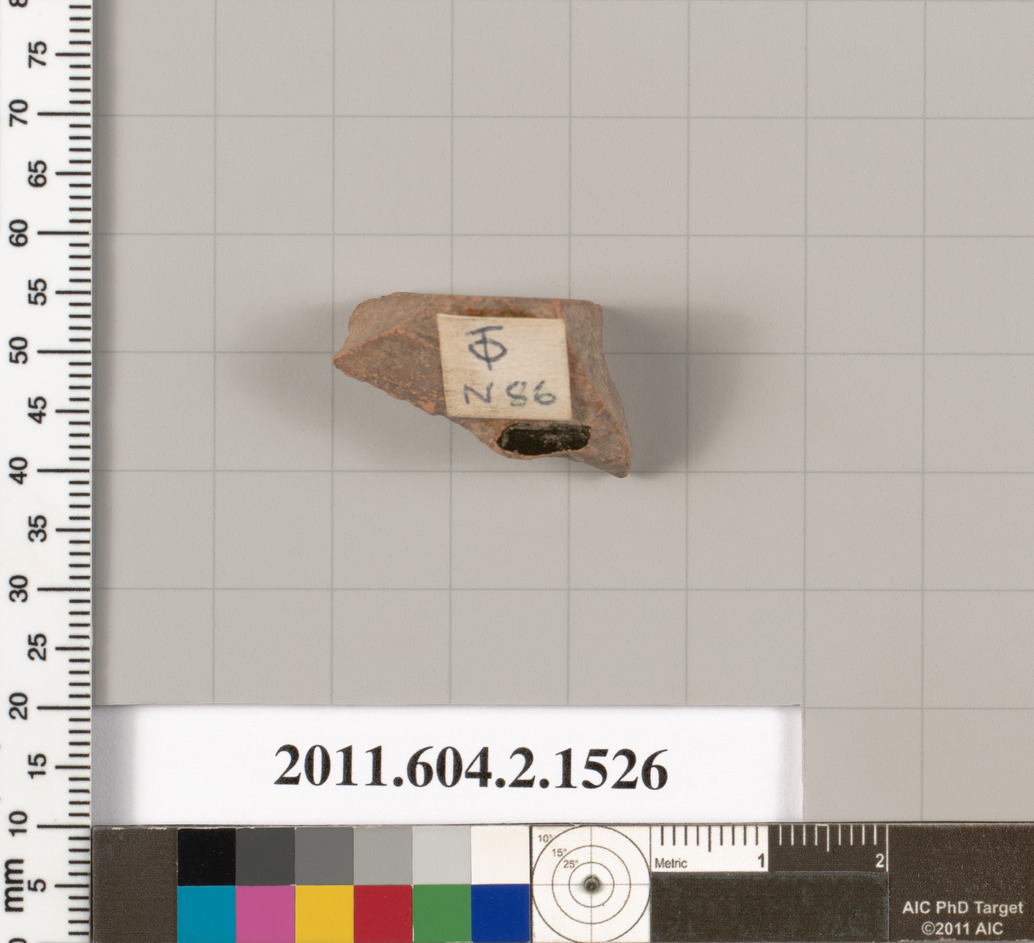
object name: skyphos fragment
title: Terracotta fragment of a skyphos (deep drinking cup)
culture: greek, attic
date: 600-401 BCE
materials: terracotta